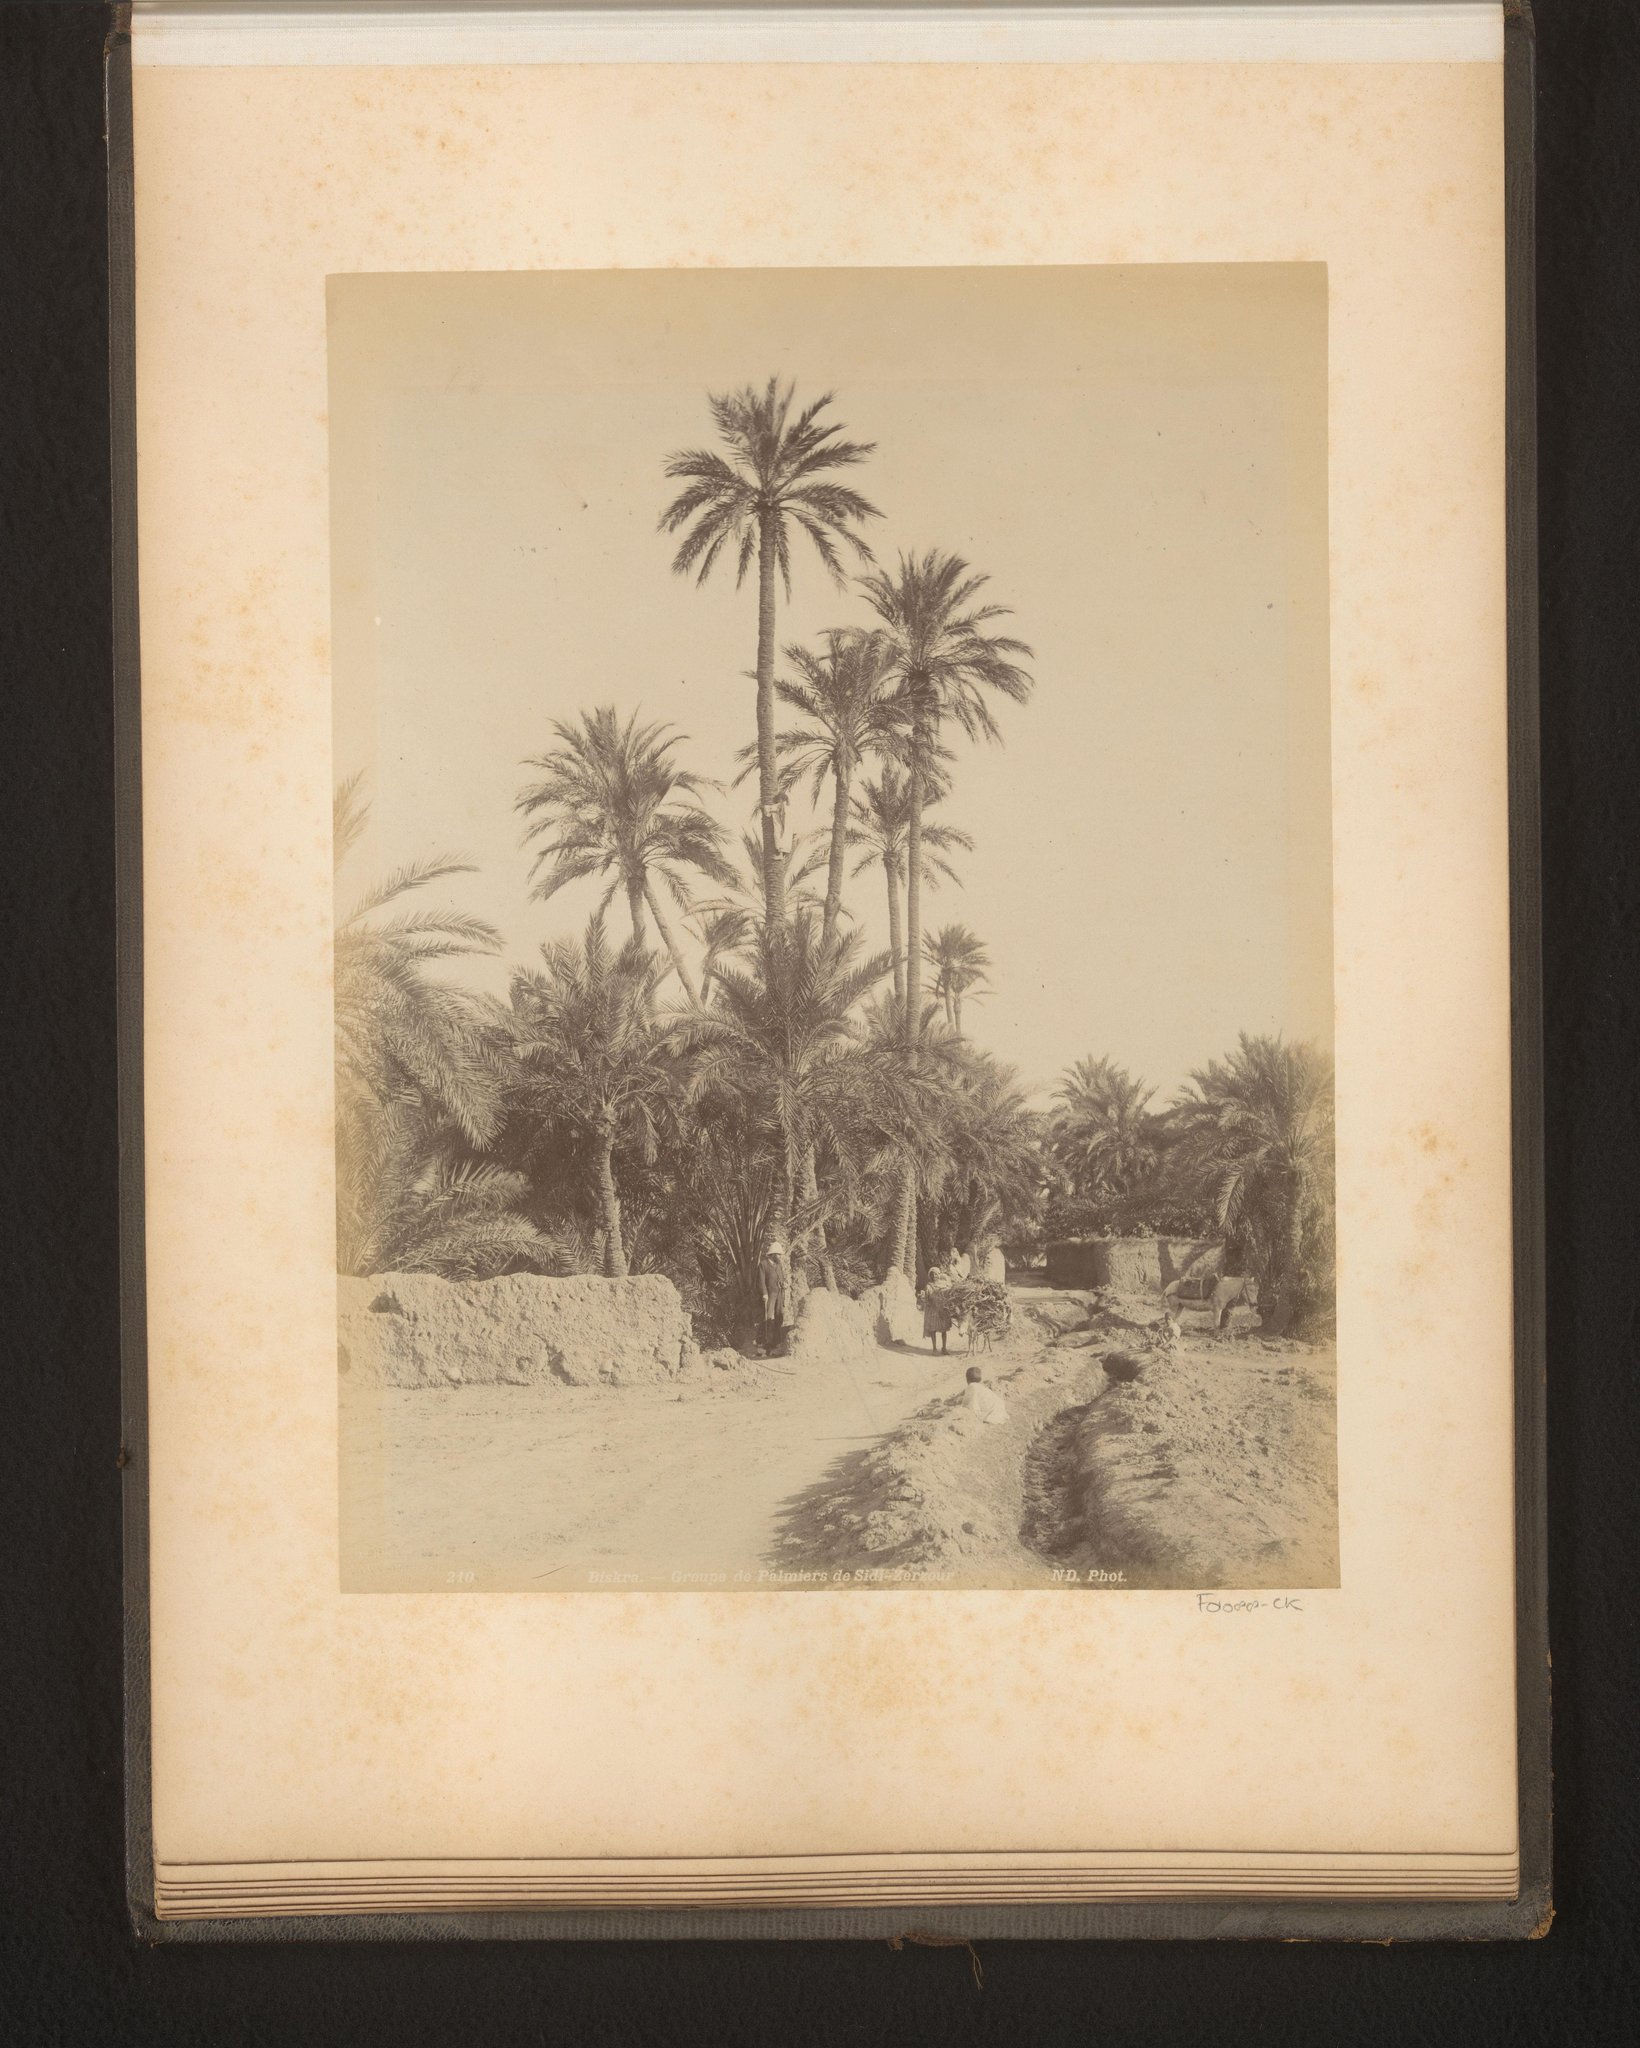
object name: photograph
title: Biskra. - Groupe de Palmeirs de Sidi - Zerzour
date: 1880-1900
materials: photographic support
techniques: albumen print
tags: historical persons, road, path, trees: palm-tree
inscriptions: check stamp: ‘J. Kuhn Editeur/ 220 Rue de Rivoli Paris’, number: ‘210’